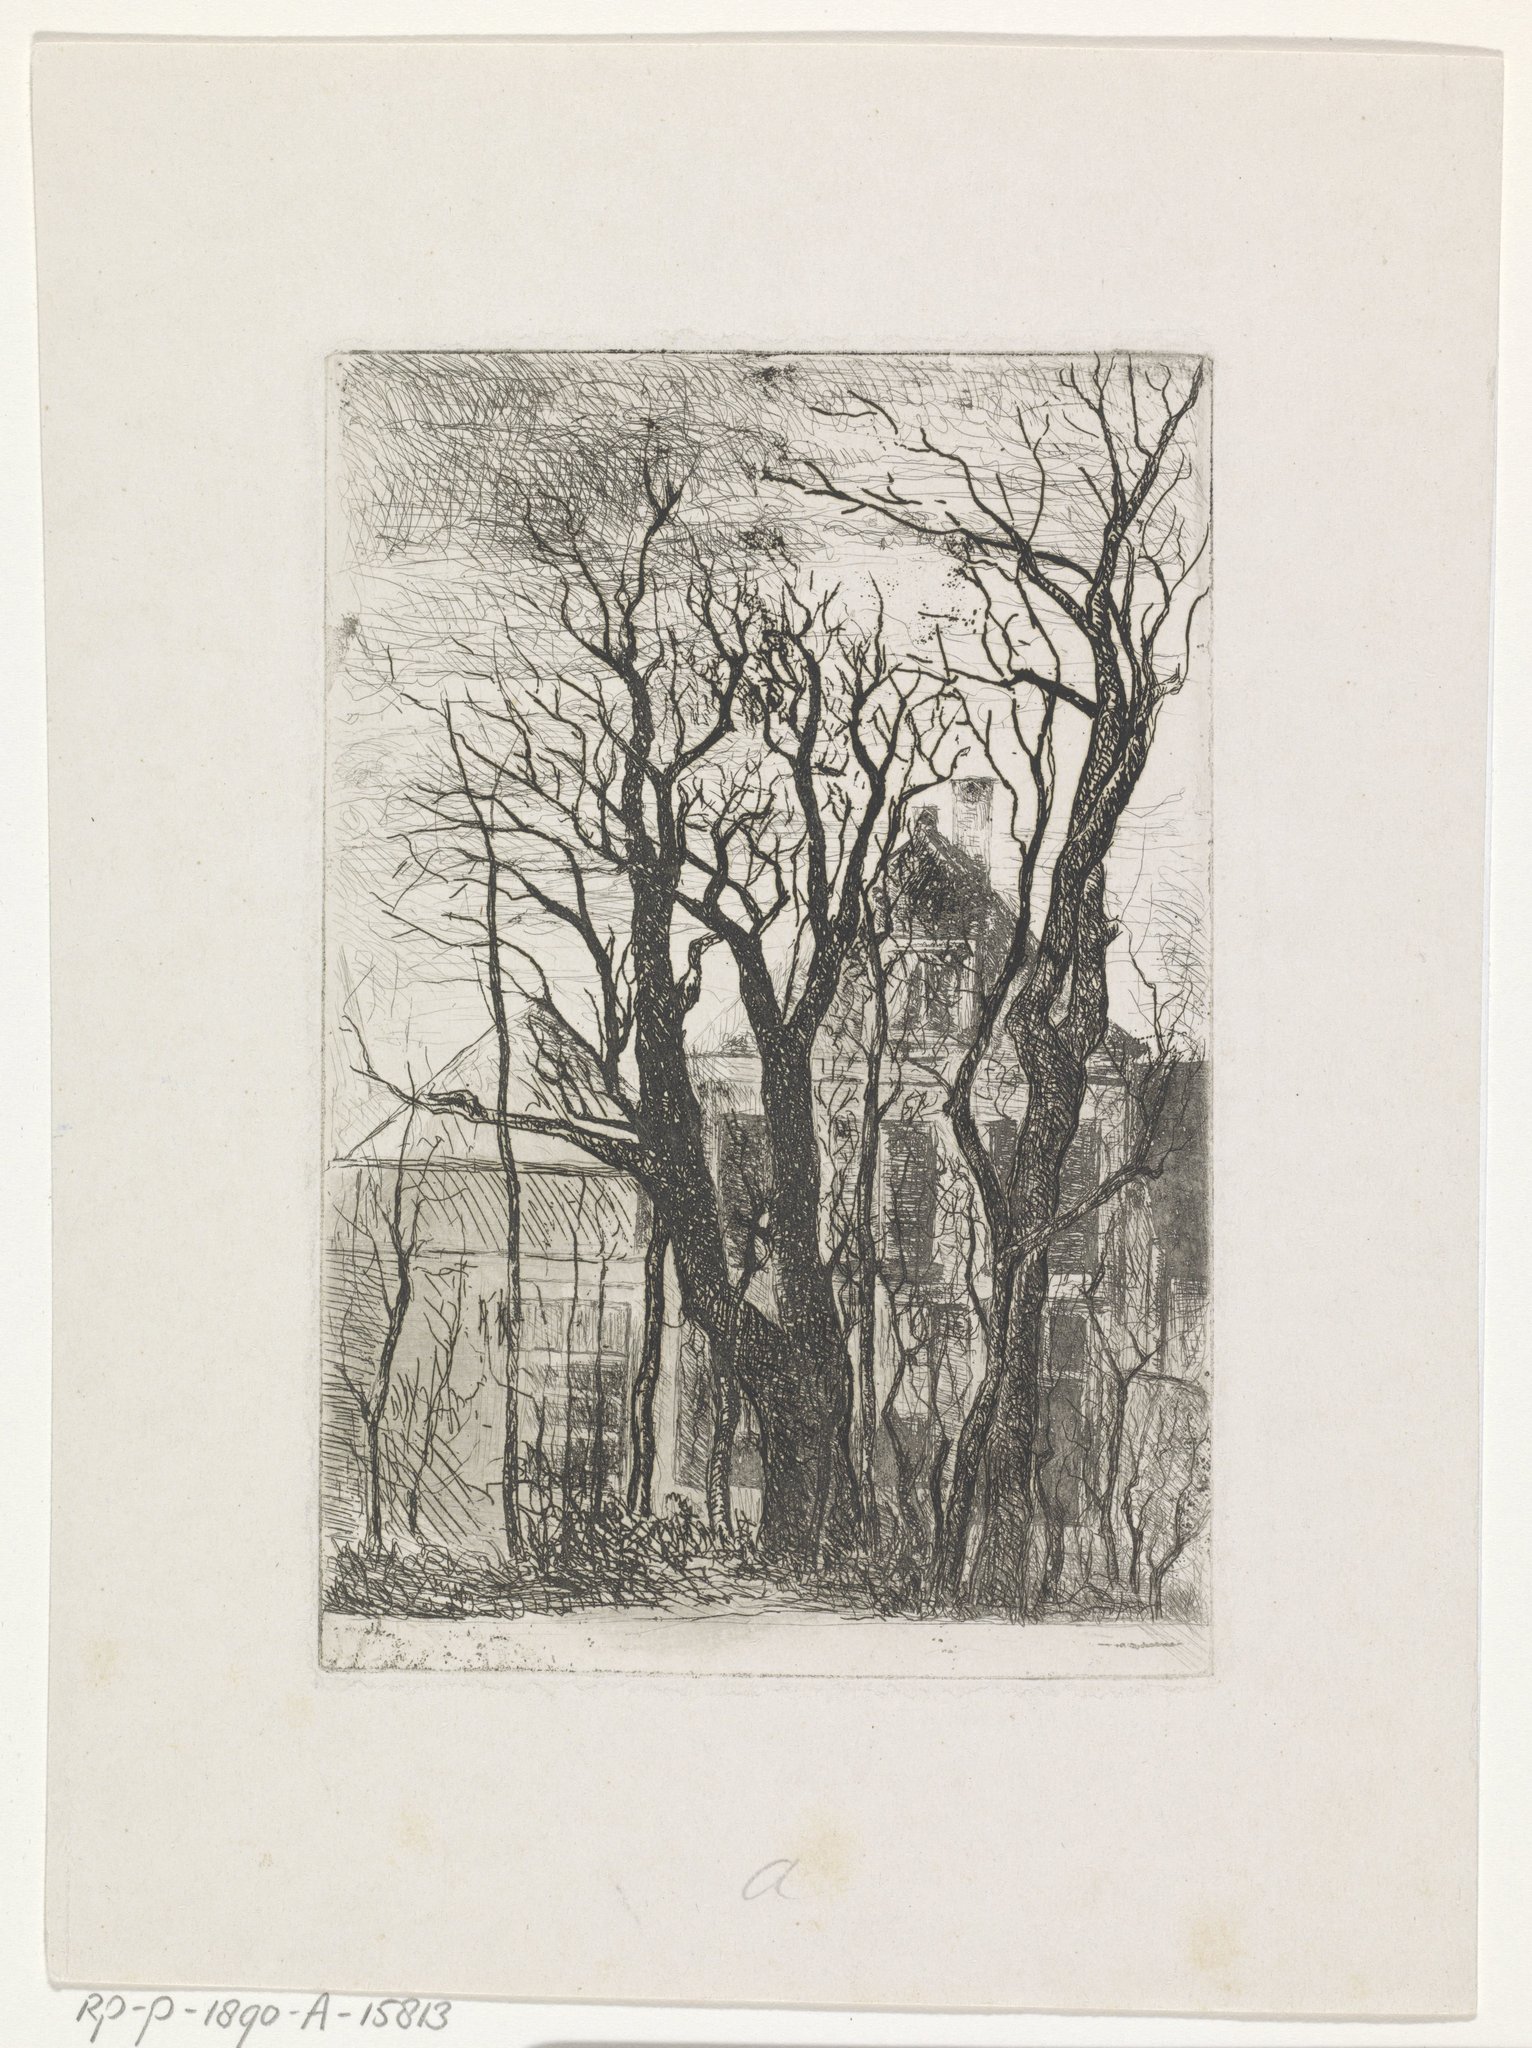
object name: print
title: Groep bomen voor twee huizen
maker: Anonymous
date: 1800-1890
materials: paper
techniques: etching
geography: netherlands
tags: groups of trees, the usual house or row of houses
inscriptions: collector's mark: Lugt 2228